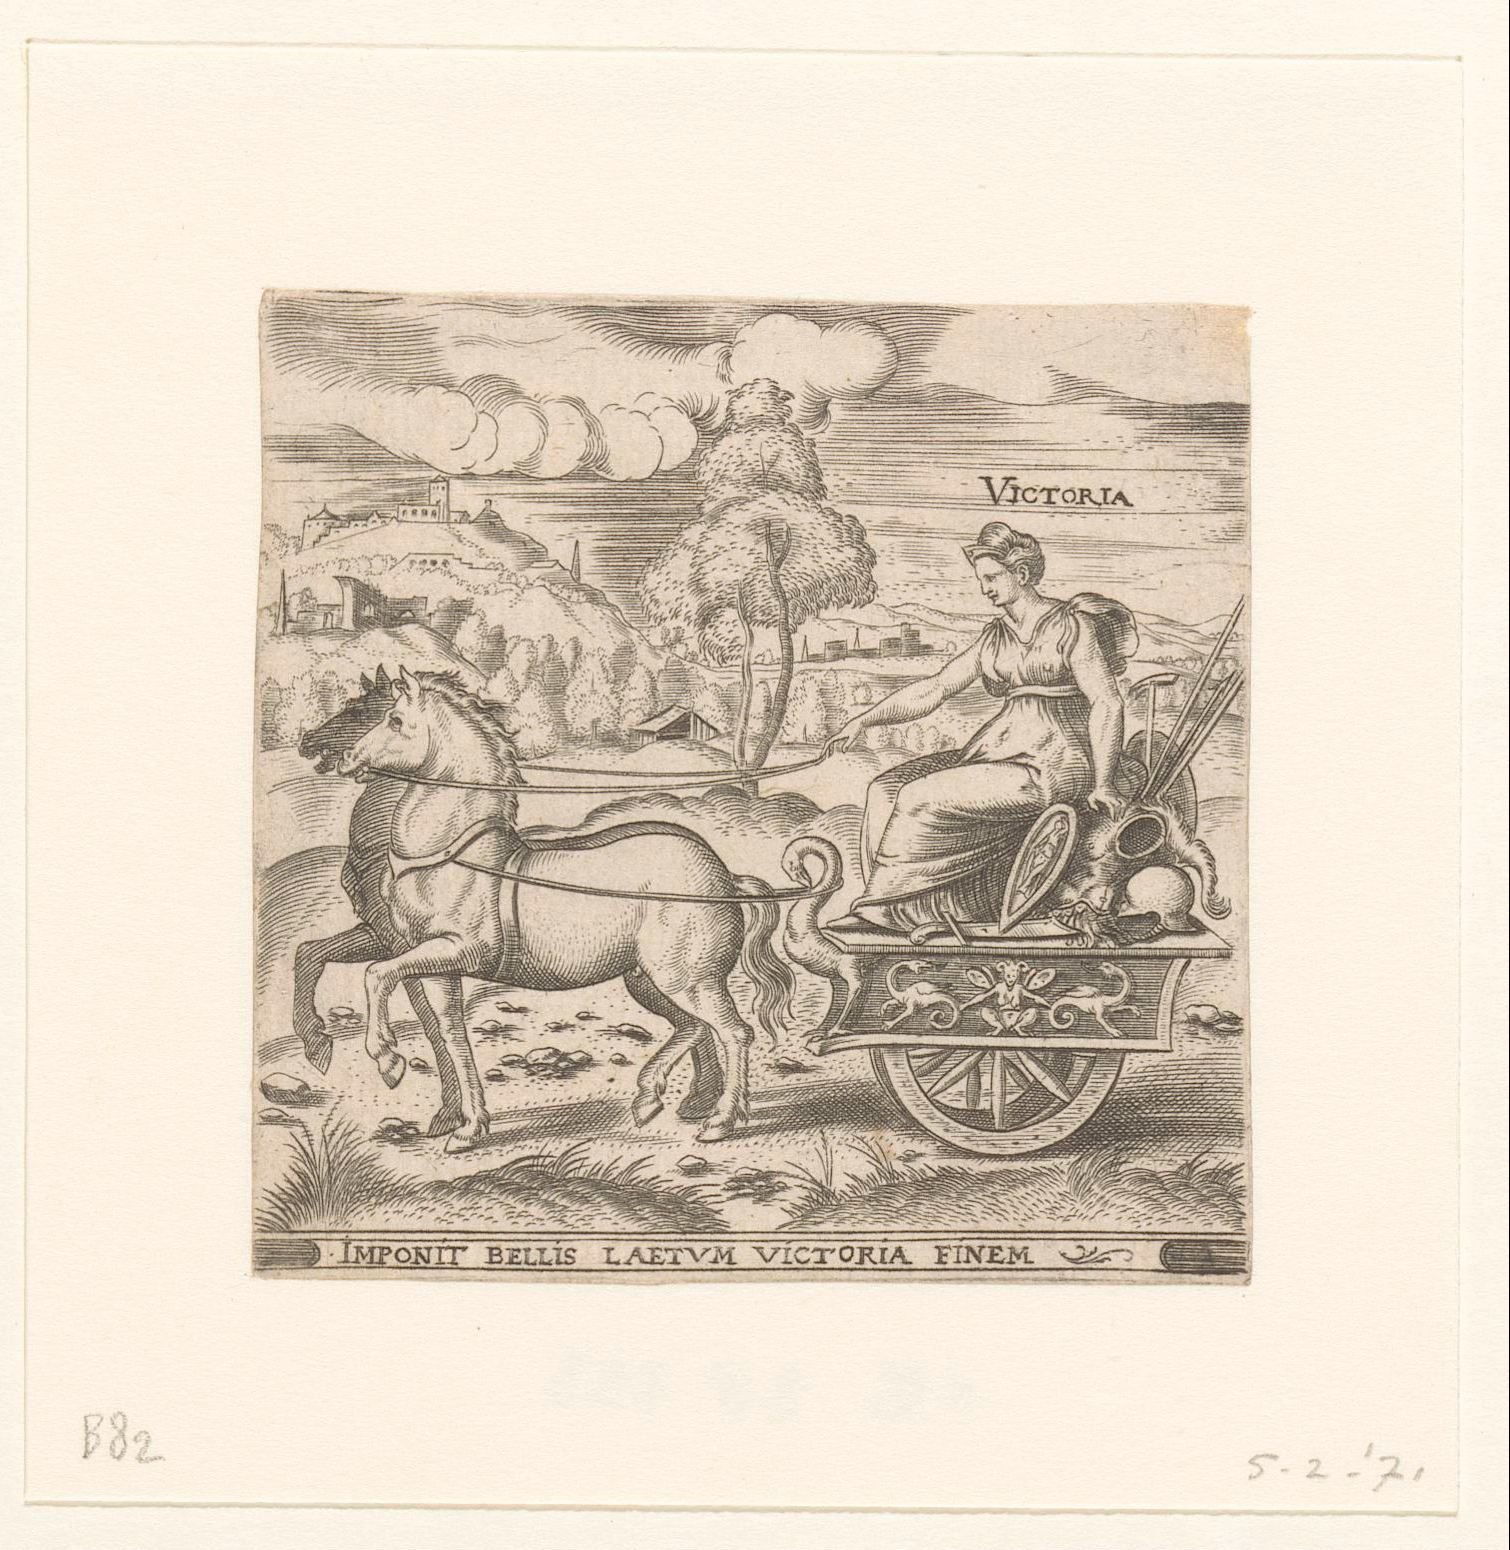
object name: print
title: Emblematische figuren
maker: francesco salviati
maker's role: draughtsman, painter, print maker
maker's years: 1510-1563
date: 1533-1567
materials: paper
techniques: engraving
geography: italy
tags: 'victoria'; 'vittoria', 'vittoria navale', 'vittoria degl'antichi' (ripa)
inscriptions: collector's mark: Lugt 240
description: Overwinning (Victoria) als vrouw zittend bovenop een stapel wapens, op een triomfwagen die getrokken wordt door twee paarden. Een regel Latijnse tekst in ondermarge.